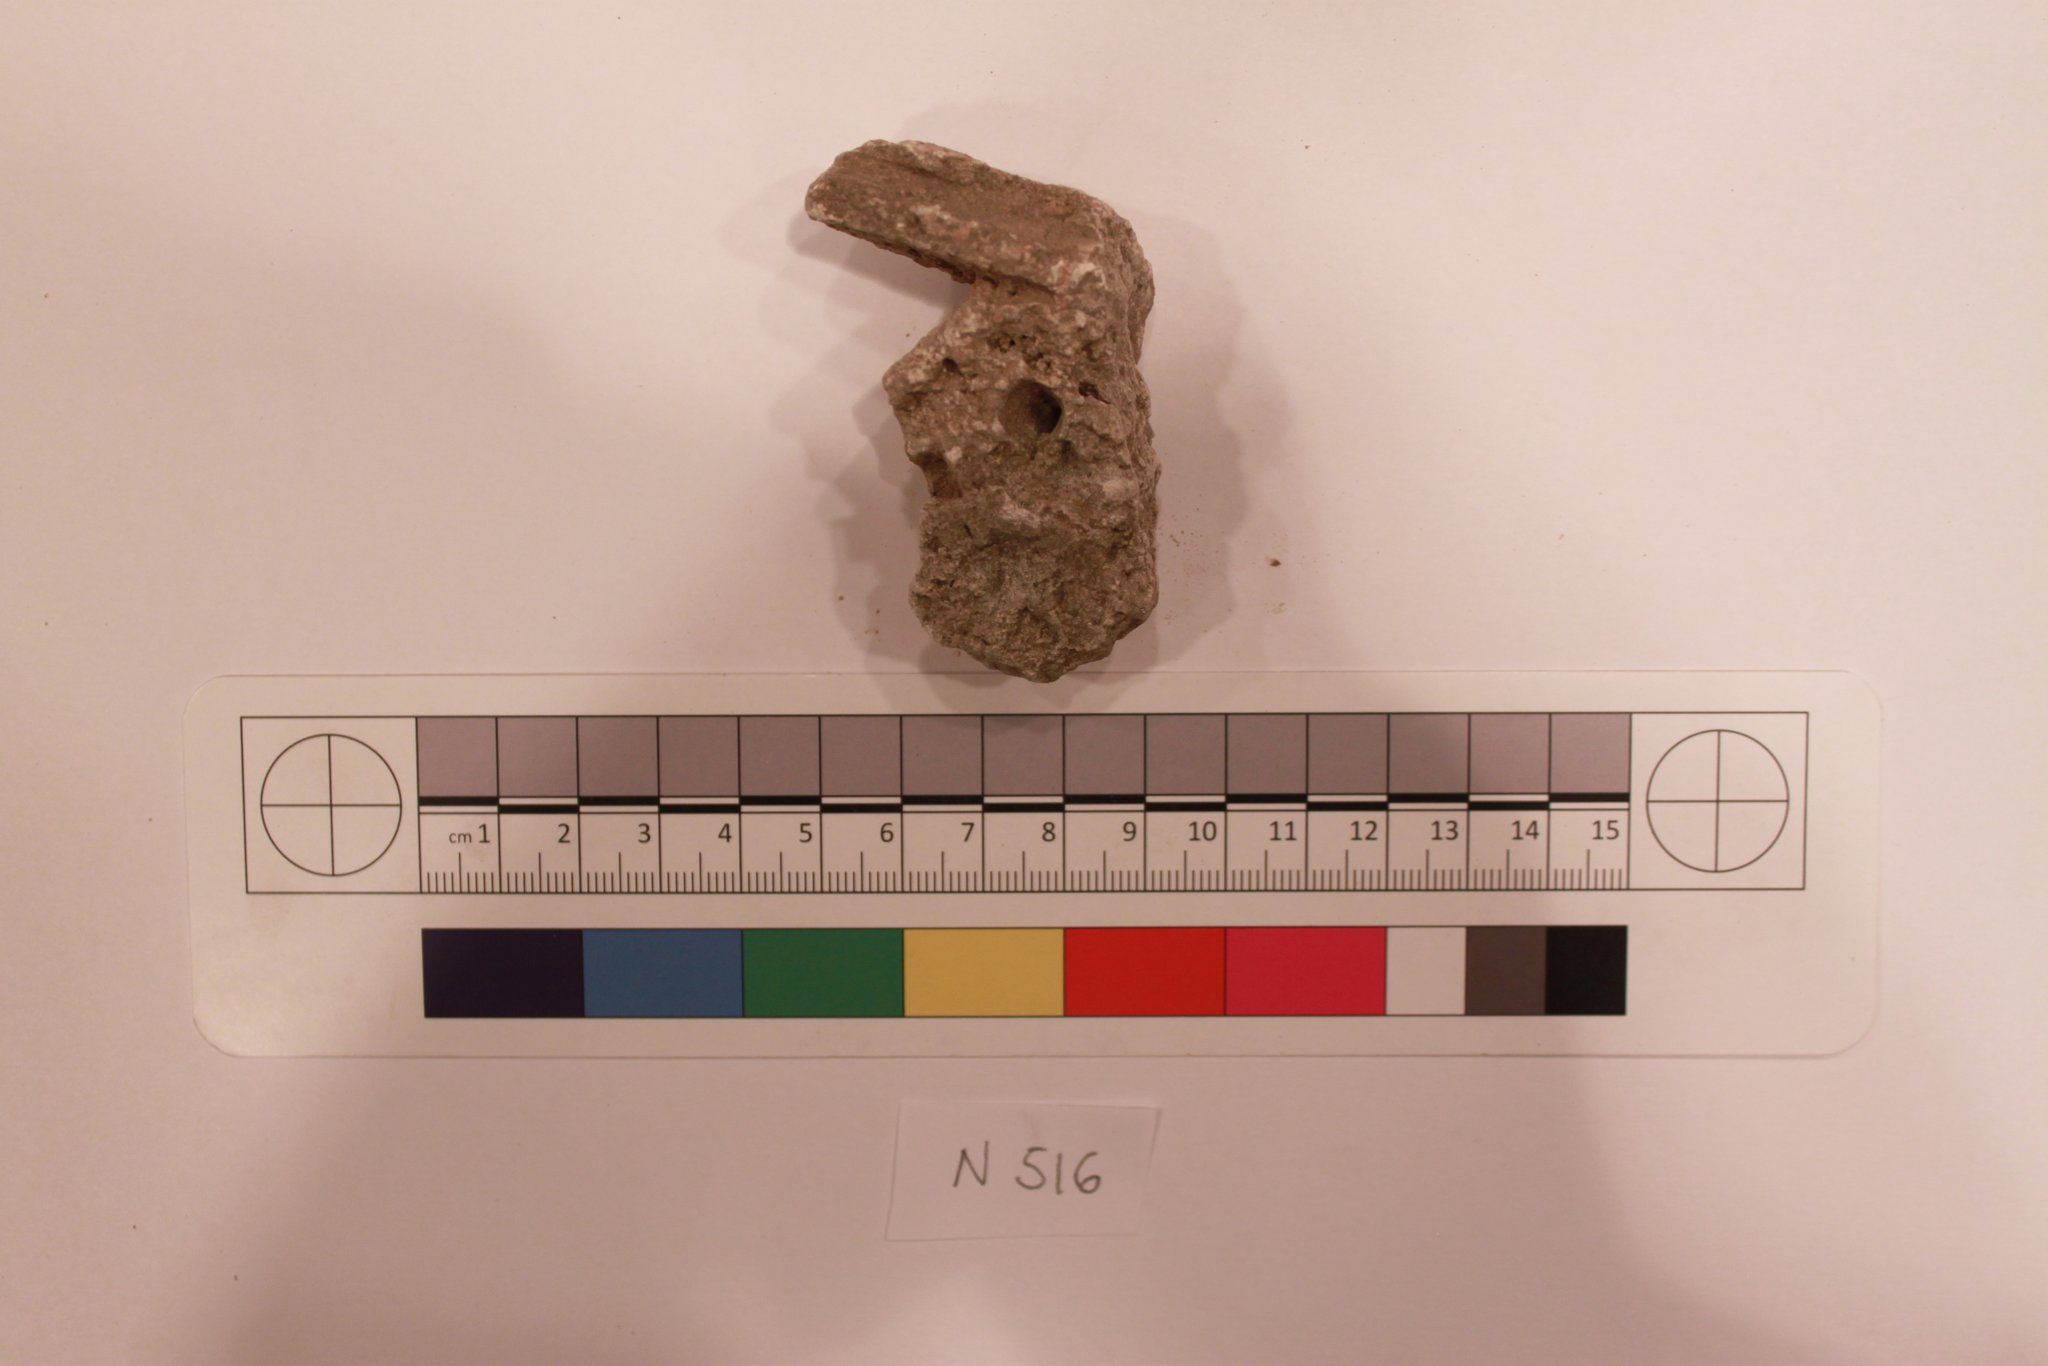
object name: fragment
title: Stucco Fragment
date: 701-1200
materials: plaster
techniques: carving, painting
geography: iran